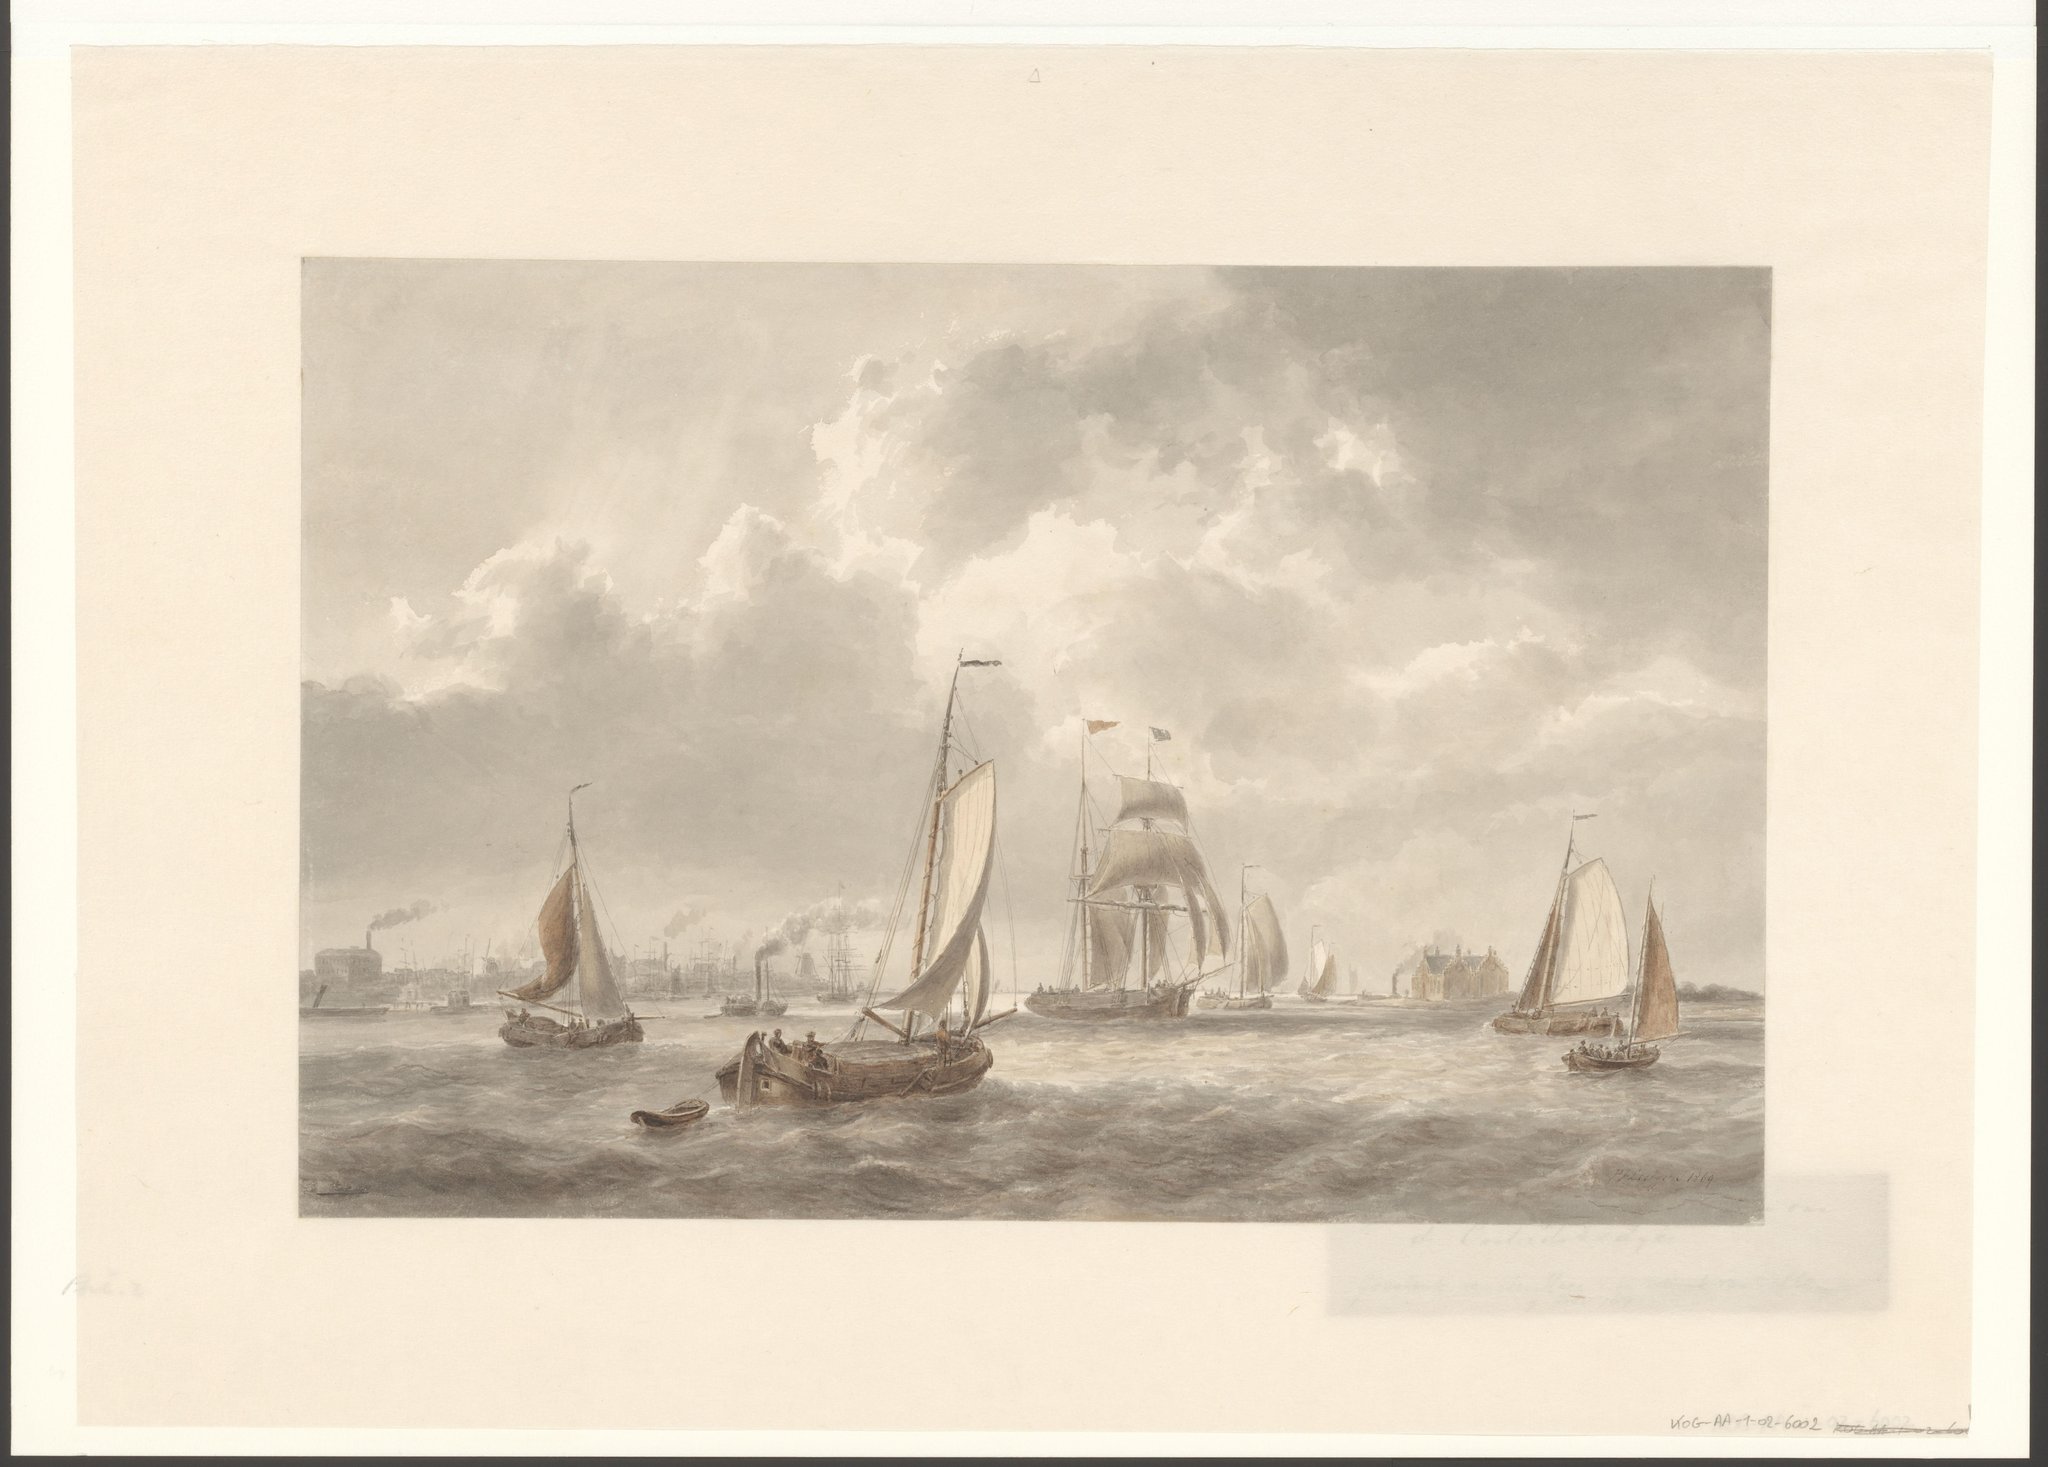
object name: drawing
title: Gezicht op het IJ en Amsterdam vanaf de Oosterdoksdijk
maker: petrus josephus lutgers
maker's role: draughtsman, print maker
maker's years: 1808-1874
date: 1869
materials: ink, paper, pencil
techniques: brush, pen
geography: amsterdam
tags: sailing-ship, sailing-boat, city-view in general; 'veduta', river, amsterdam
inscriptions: inscription: ‘Gezigt op het (...) 9 nov 1891’, signature and date: ‘PJ Lutgers 1869.’, inscription: ‘Port 2’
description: Onderwerpsrubriek binnen de Atlas Amsterdam: Gezichten van het IJ op het westelijk gedeelte der stad, Blauwhoofd tot Nieuwebrug.